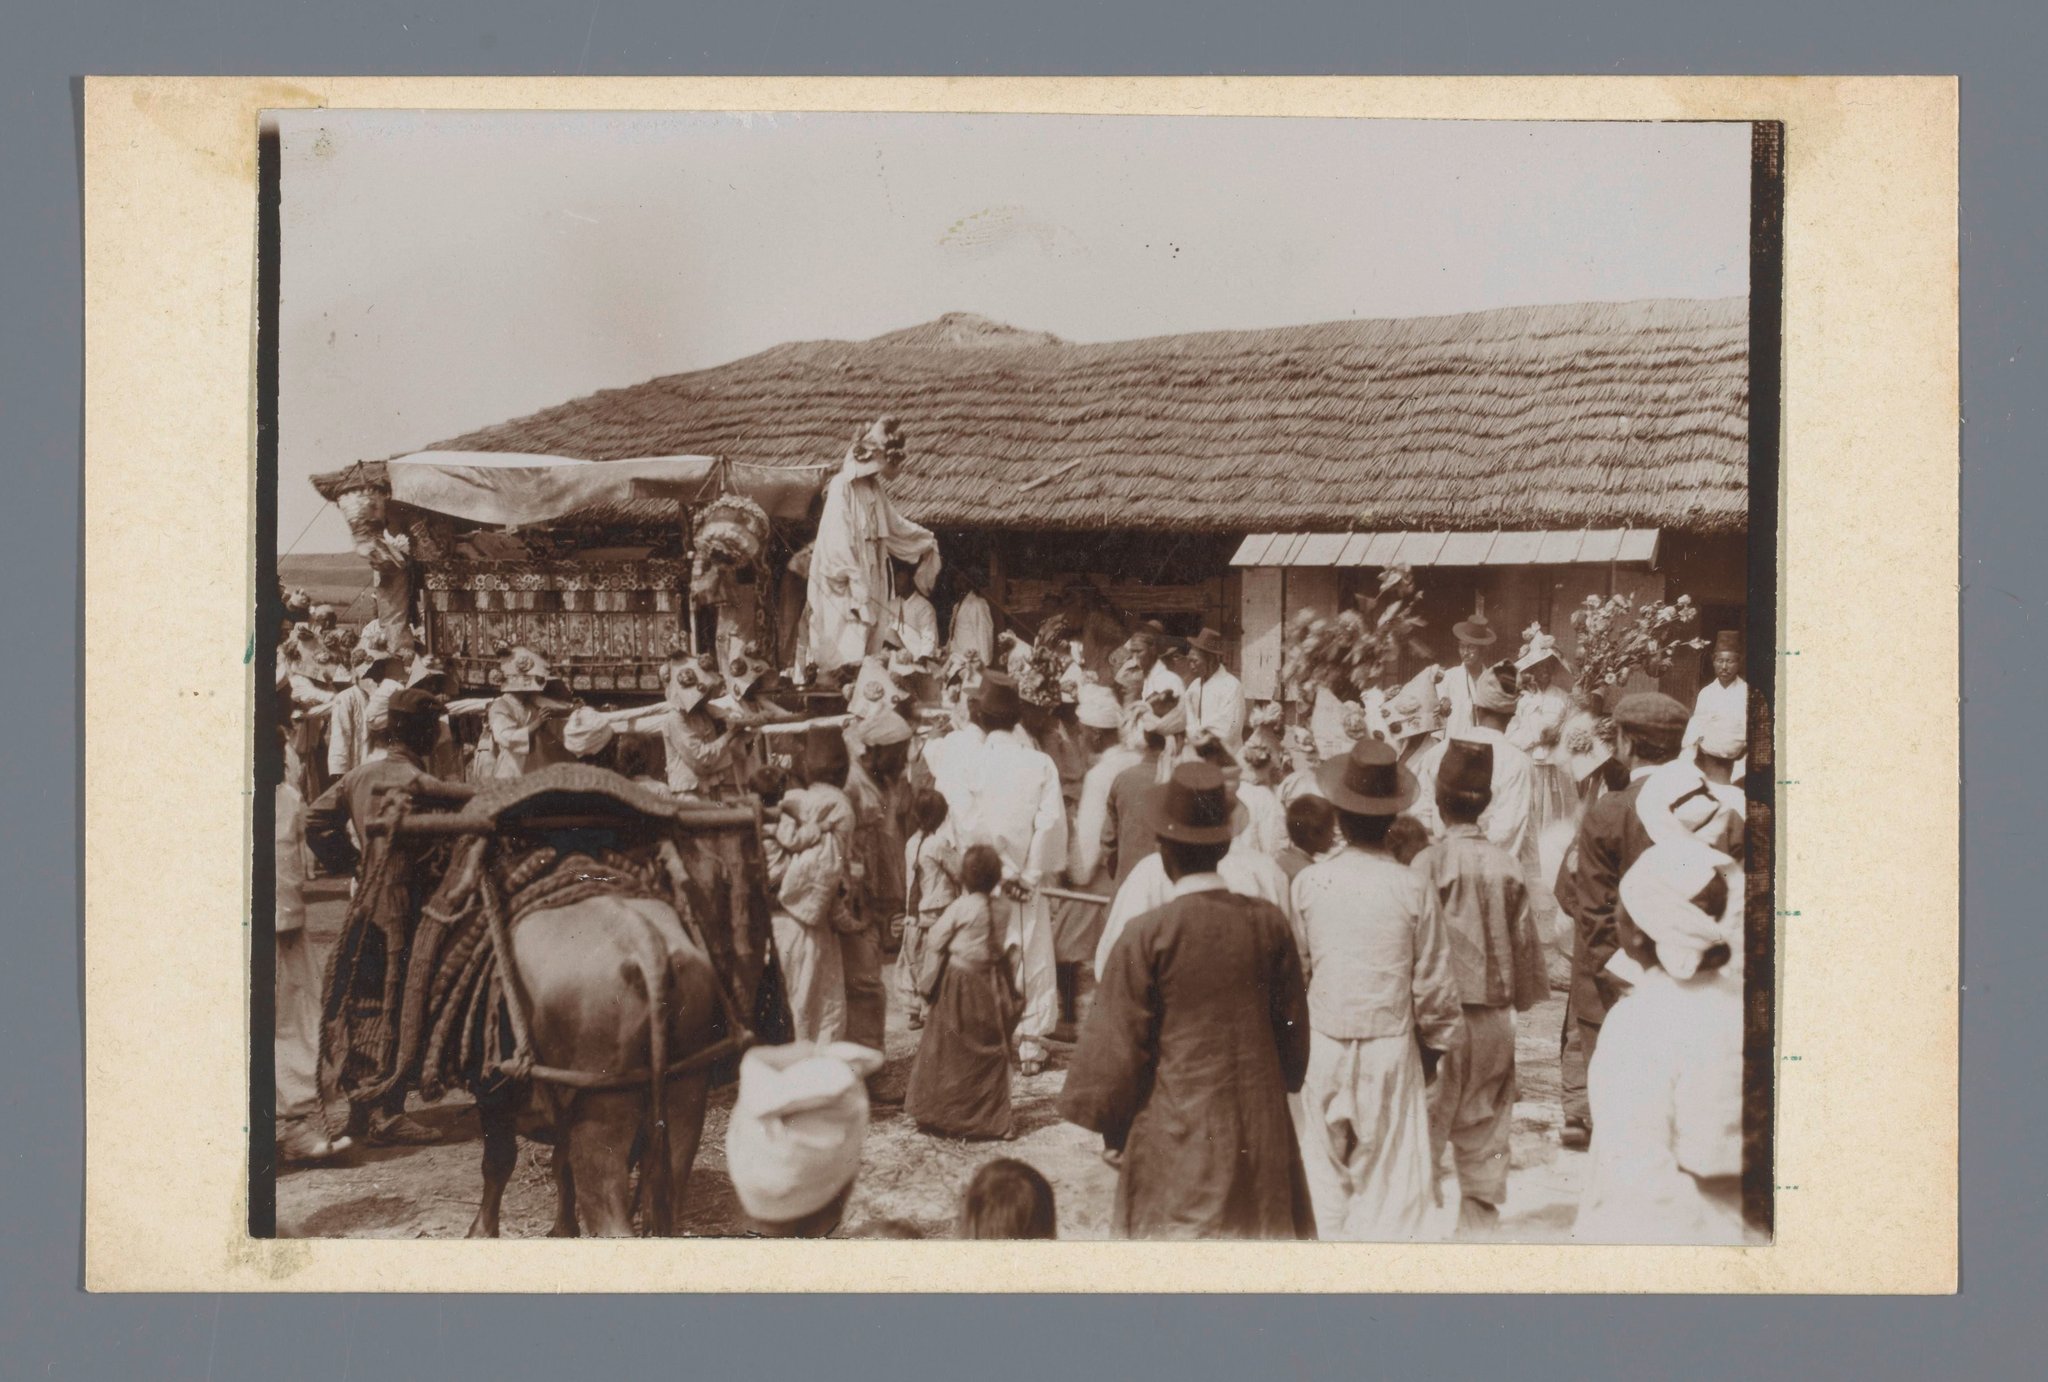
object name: photograph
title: Toeschouwers bij een optocht, China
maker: jan adriani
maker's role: fotograaf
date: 1907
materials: cardboard, photographic support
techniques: collodion silver print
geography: china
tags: street (+ city(-scape) with figures, staffage), china